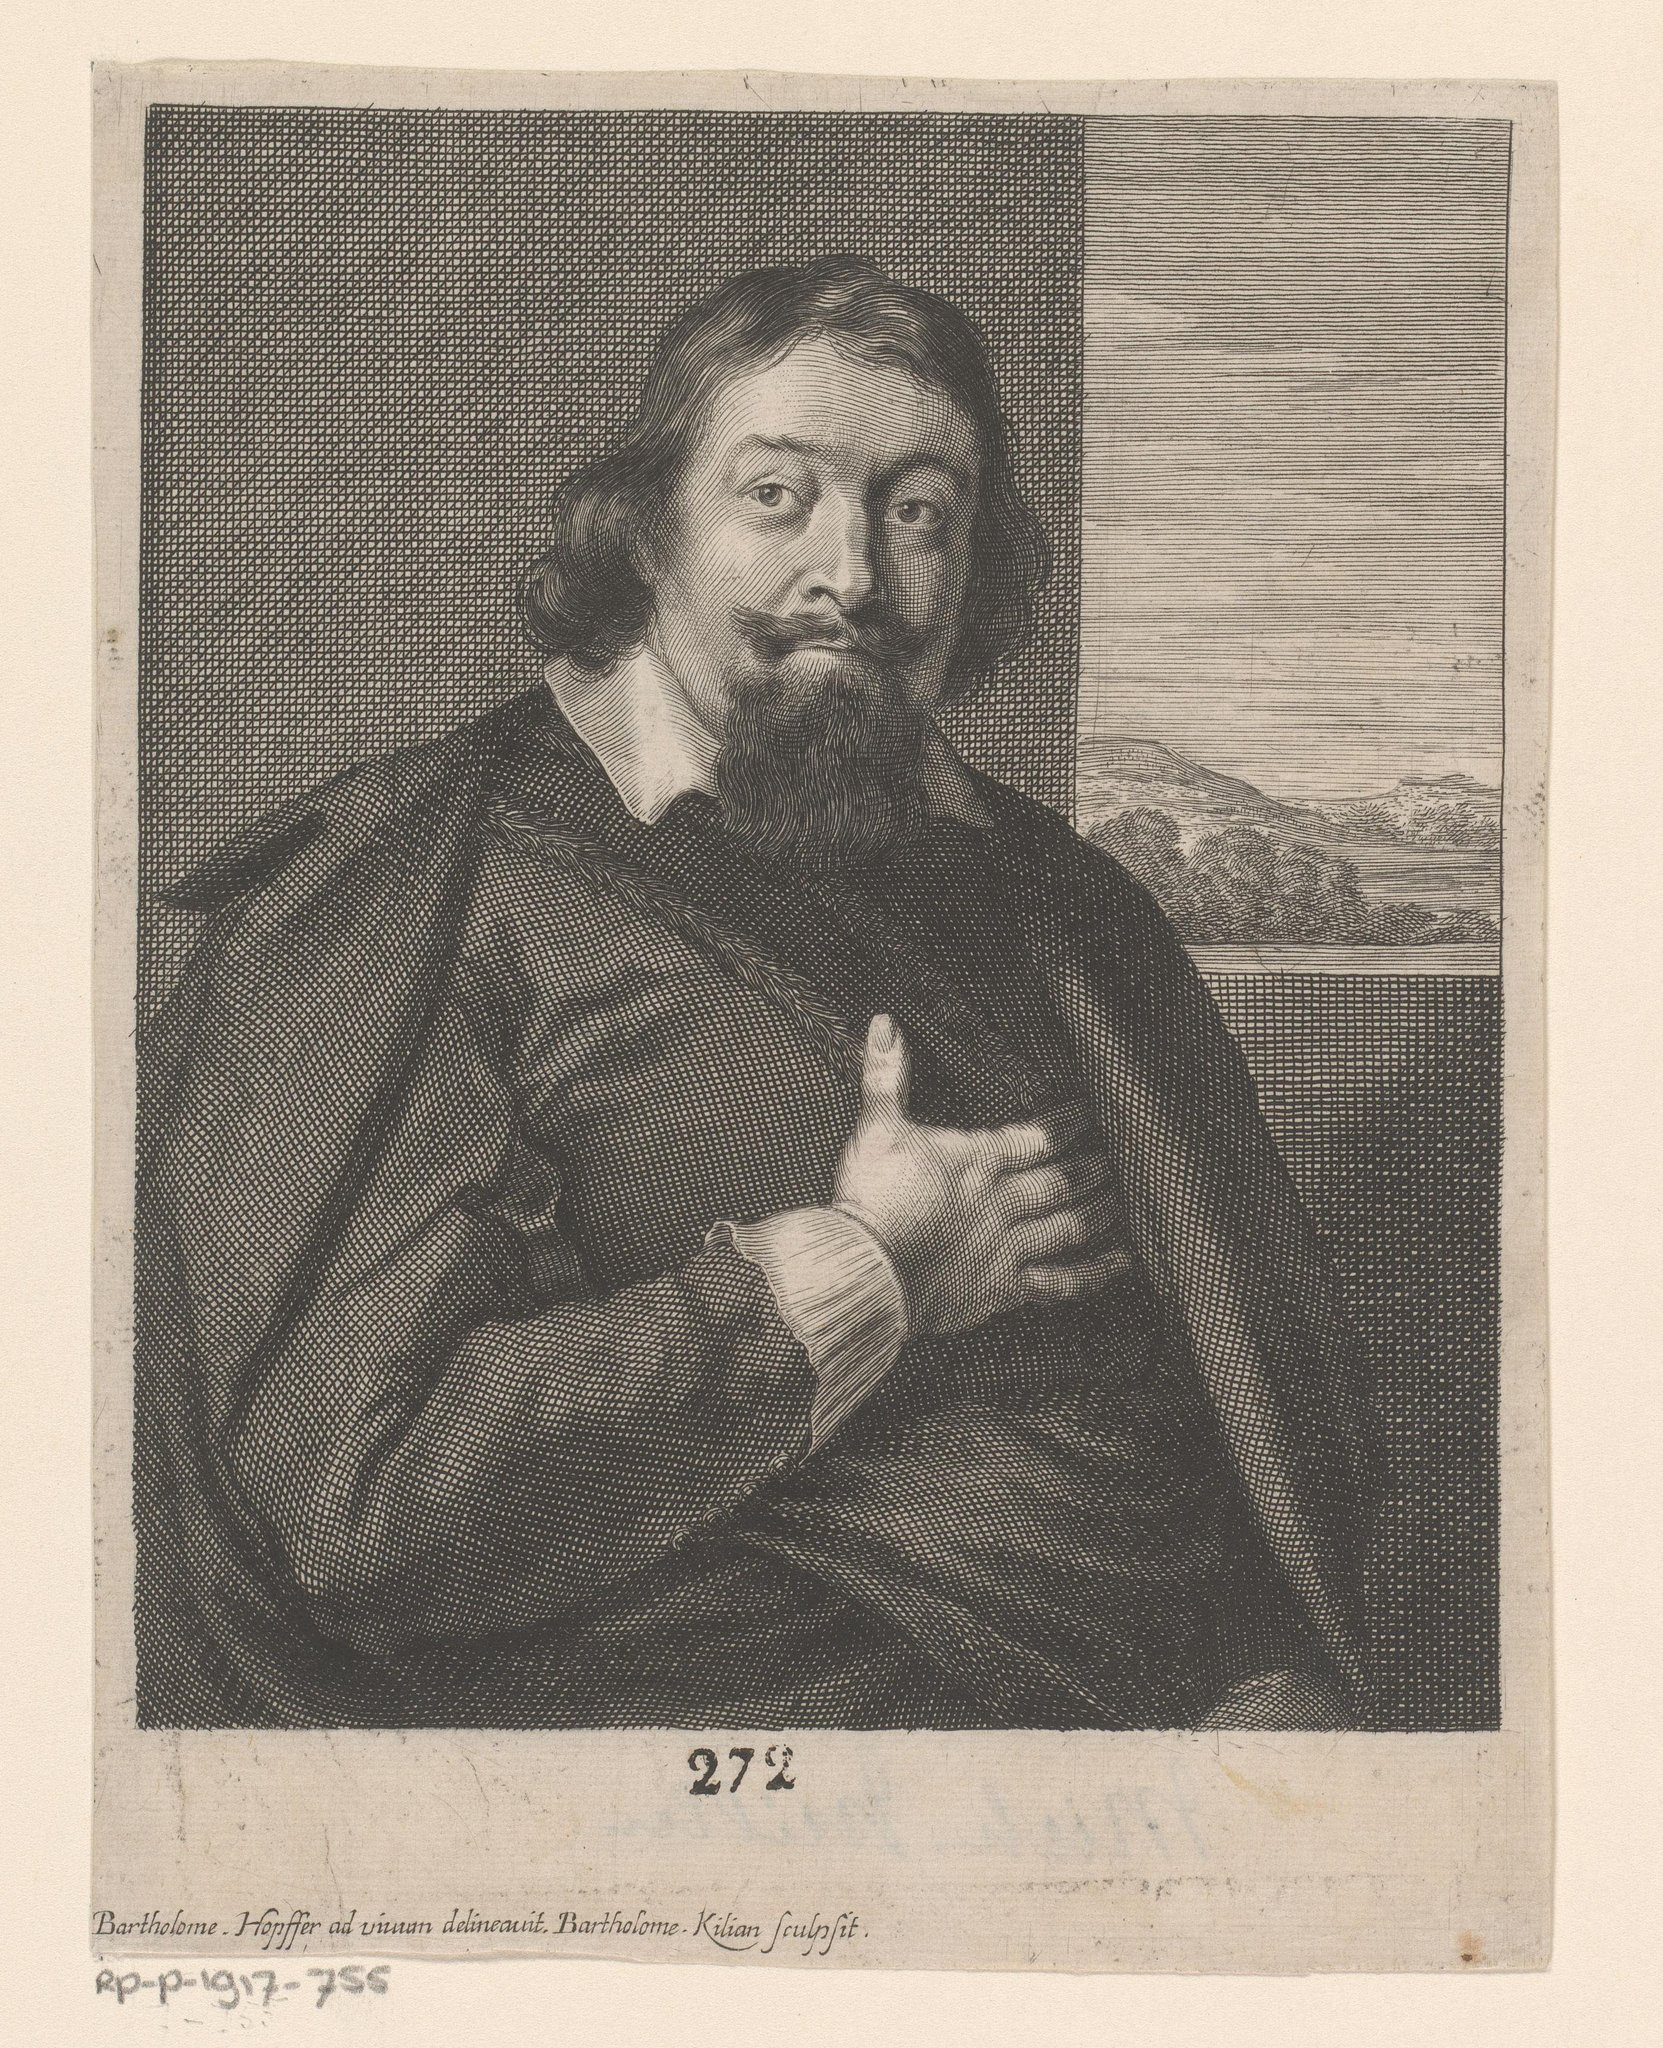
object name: print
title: Portret van Michael Miller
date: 1650-1696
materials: paper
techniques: engraving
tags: historical persons, merchant, salesman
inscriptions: number: ‘272’, collector's mark: Lugt 2228